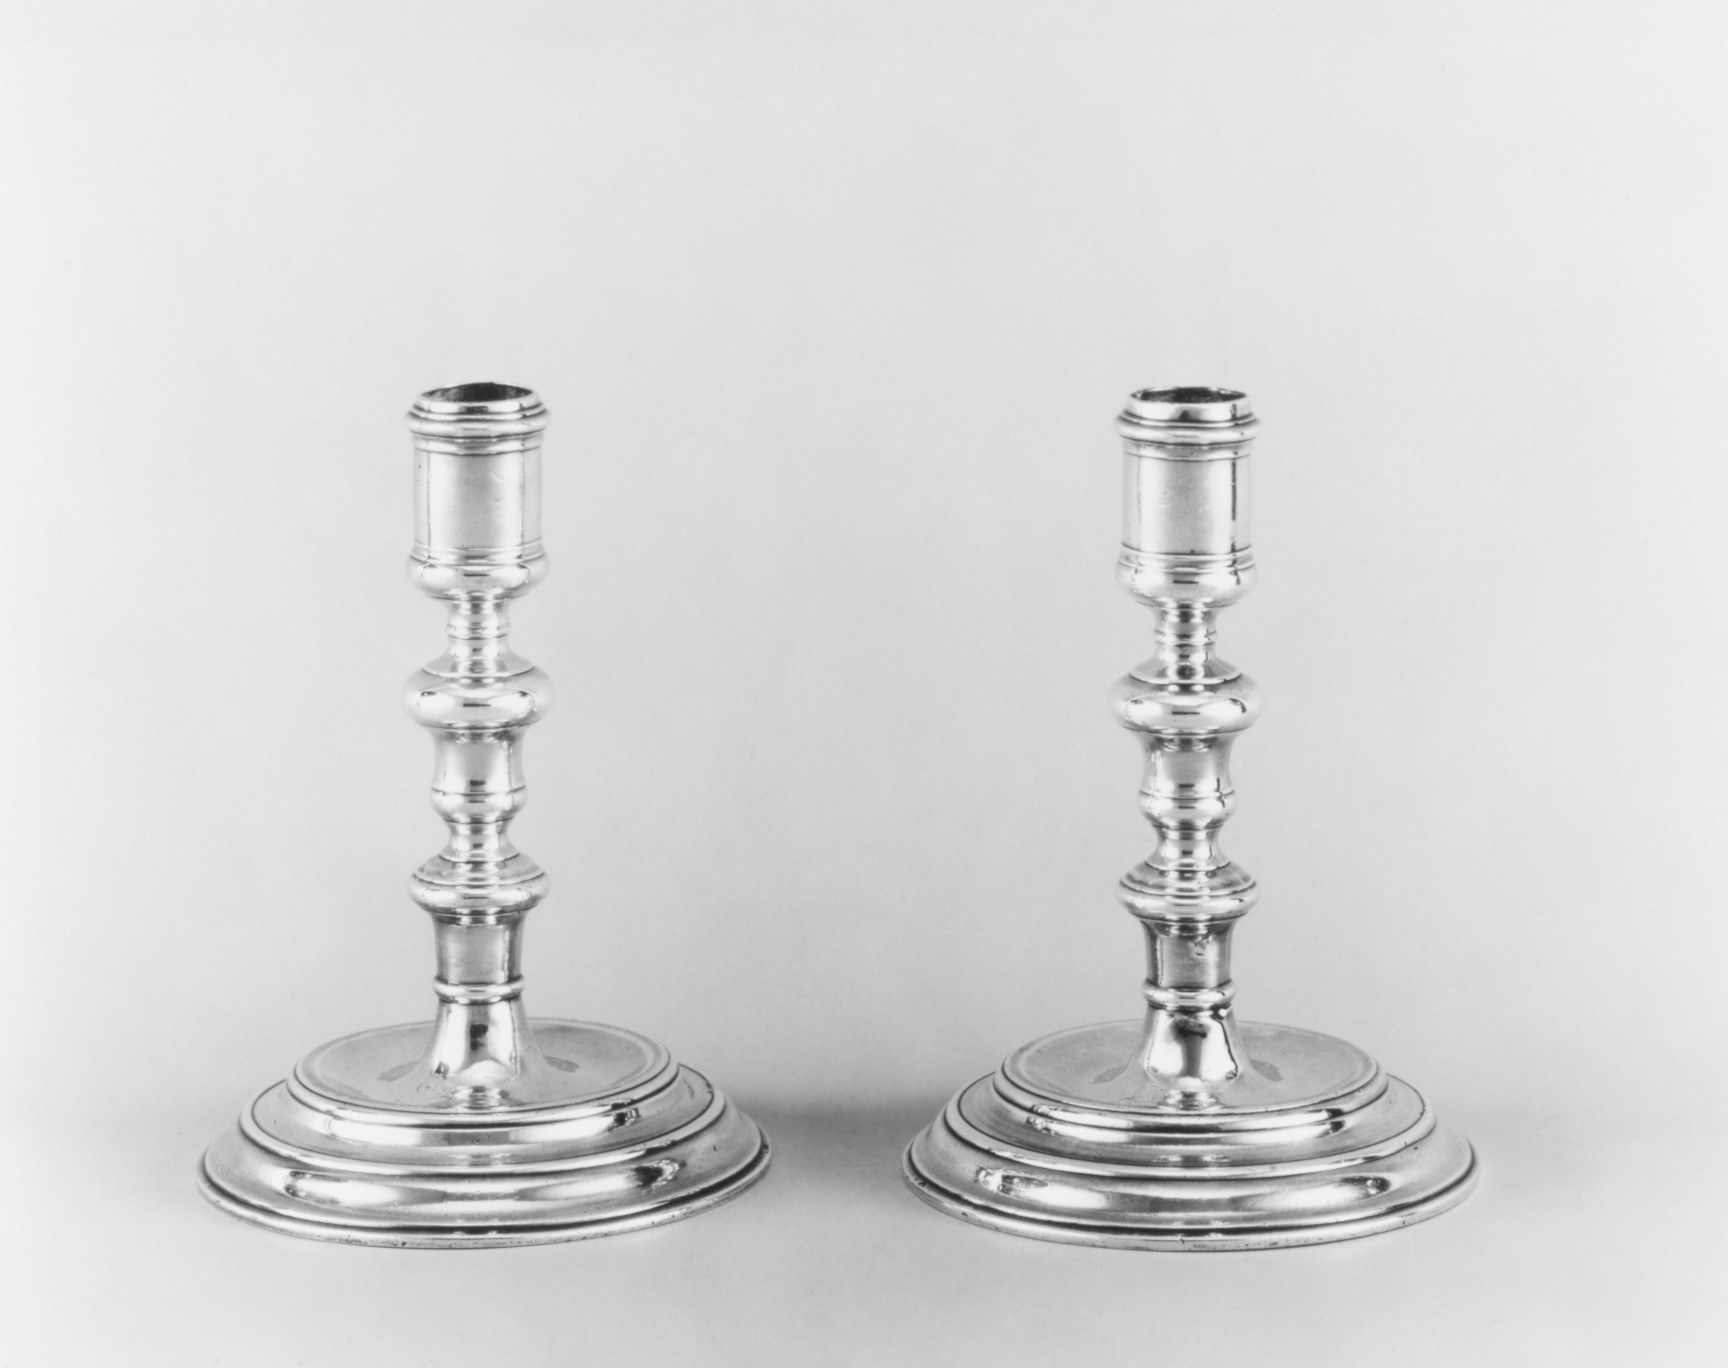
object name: candlestick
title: Pair of candlesticks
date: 1695-1696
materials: silver